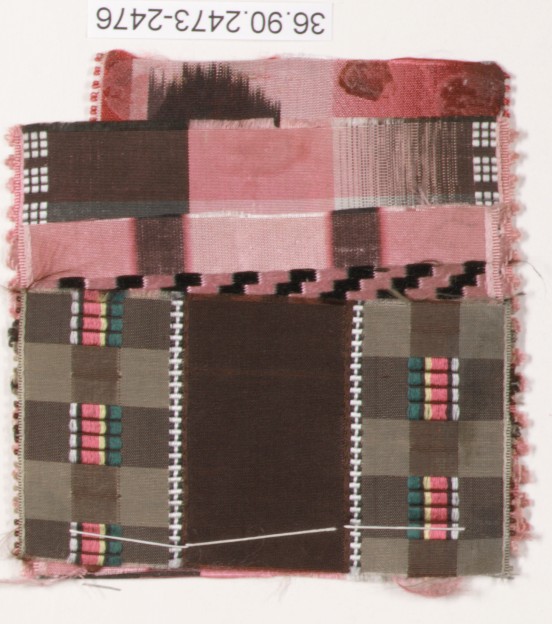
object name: ribbon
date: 1801-1900